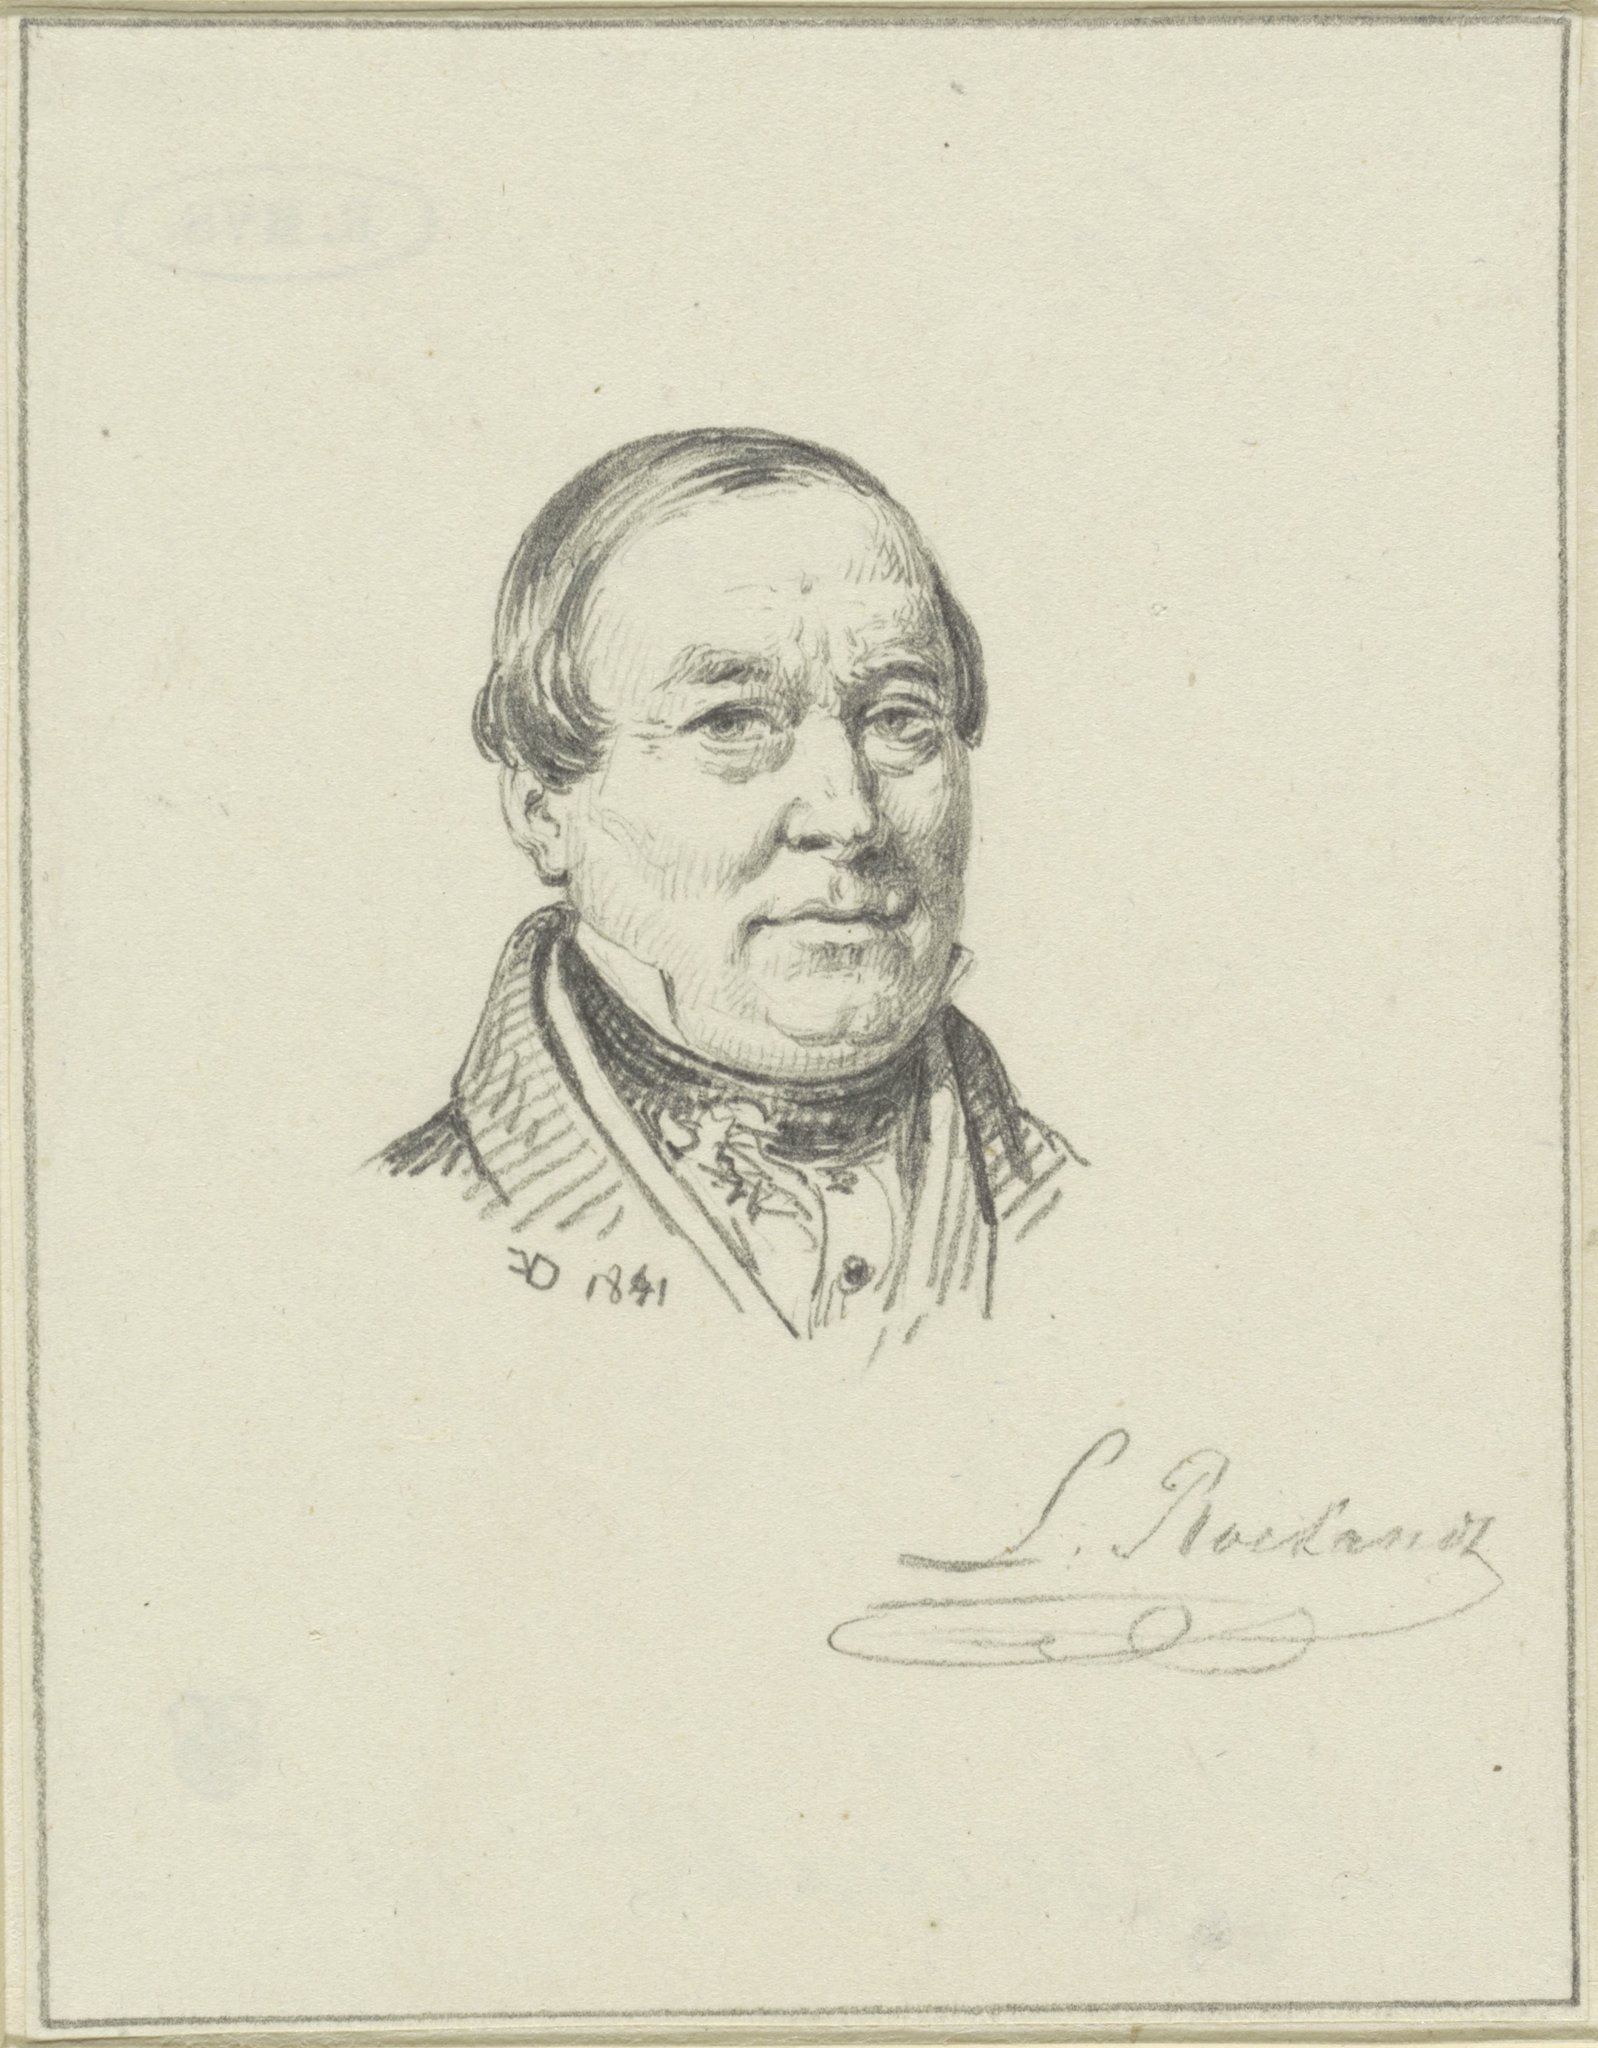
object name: drawing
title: Portret van Ludovicus Roelandt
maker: félix de vigne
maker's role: draughtsman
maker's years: 1806-1862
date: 1841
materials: paper, pencil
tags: ghent, painter, louis roelandt, historical persons, portrait, self-portrait of artist